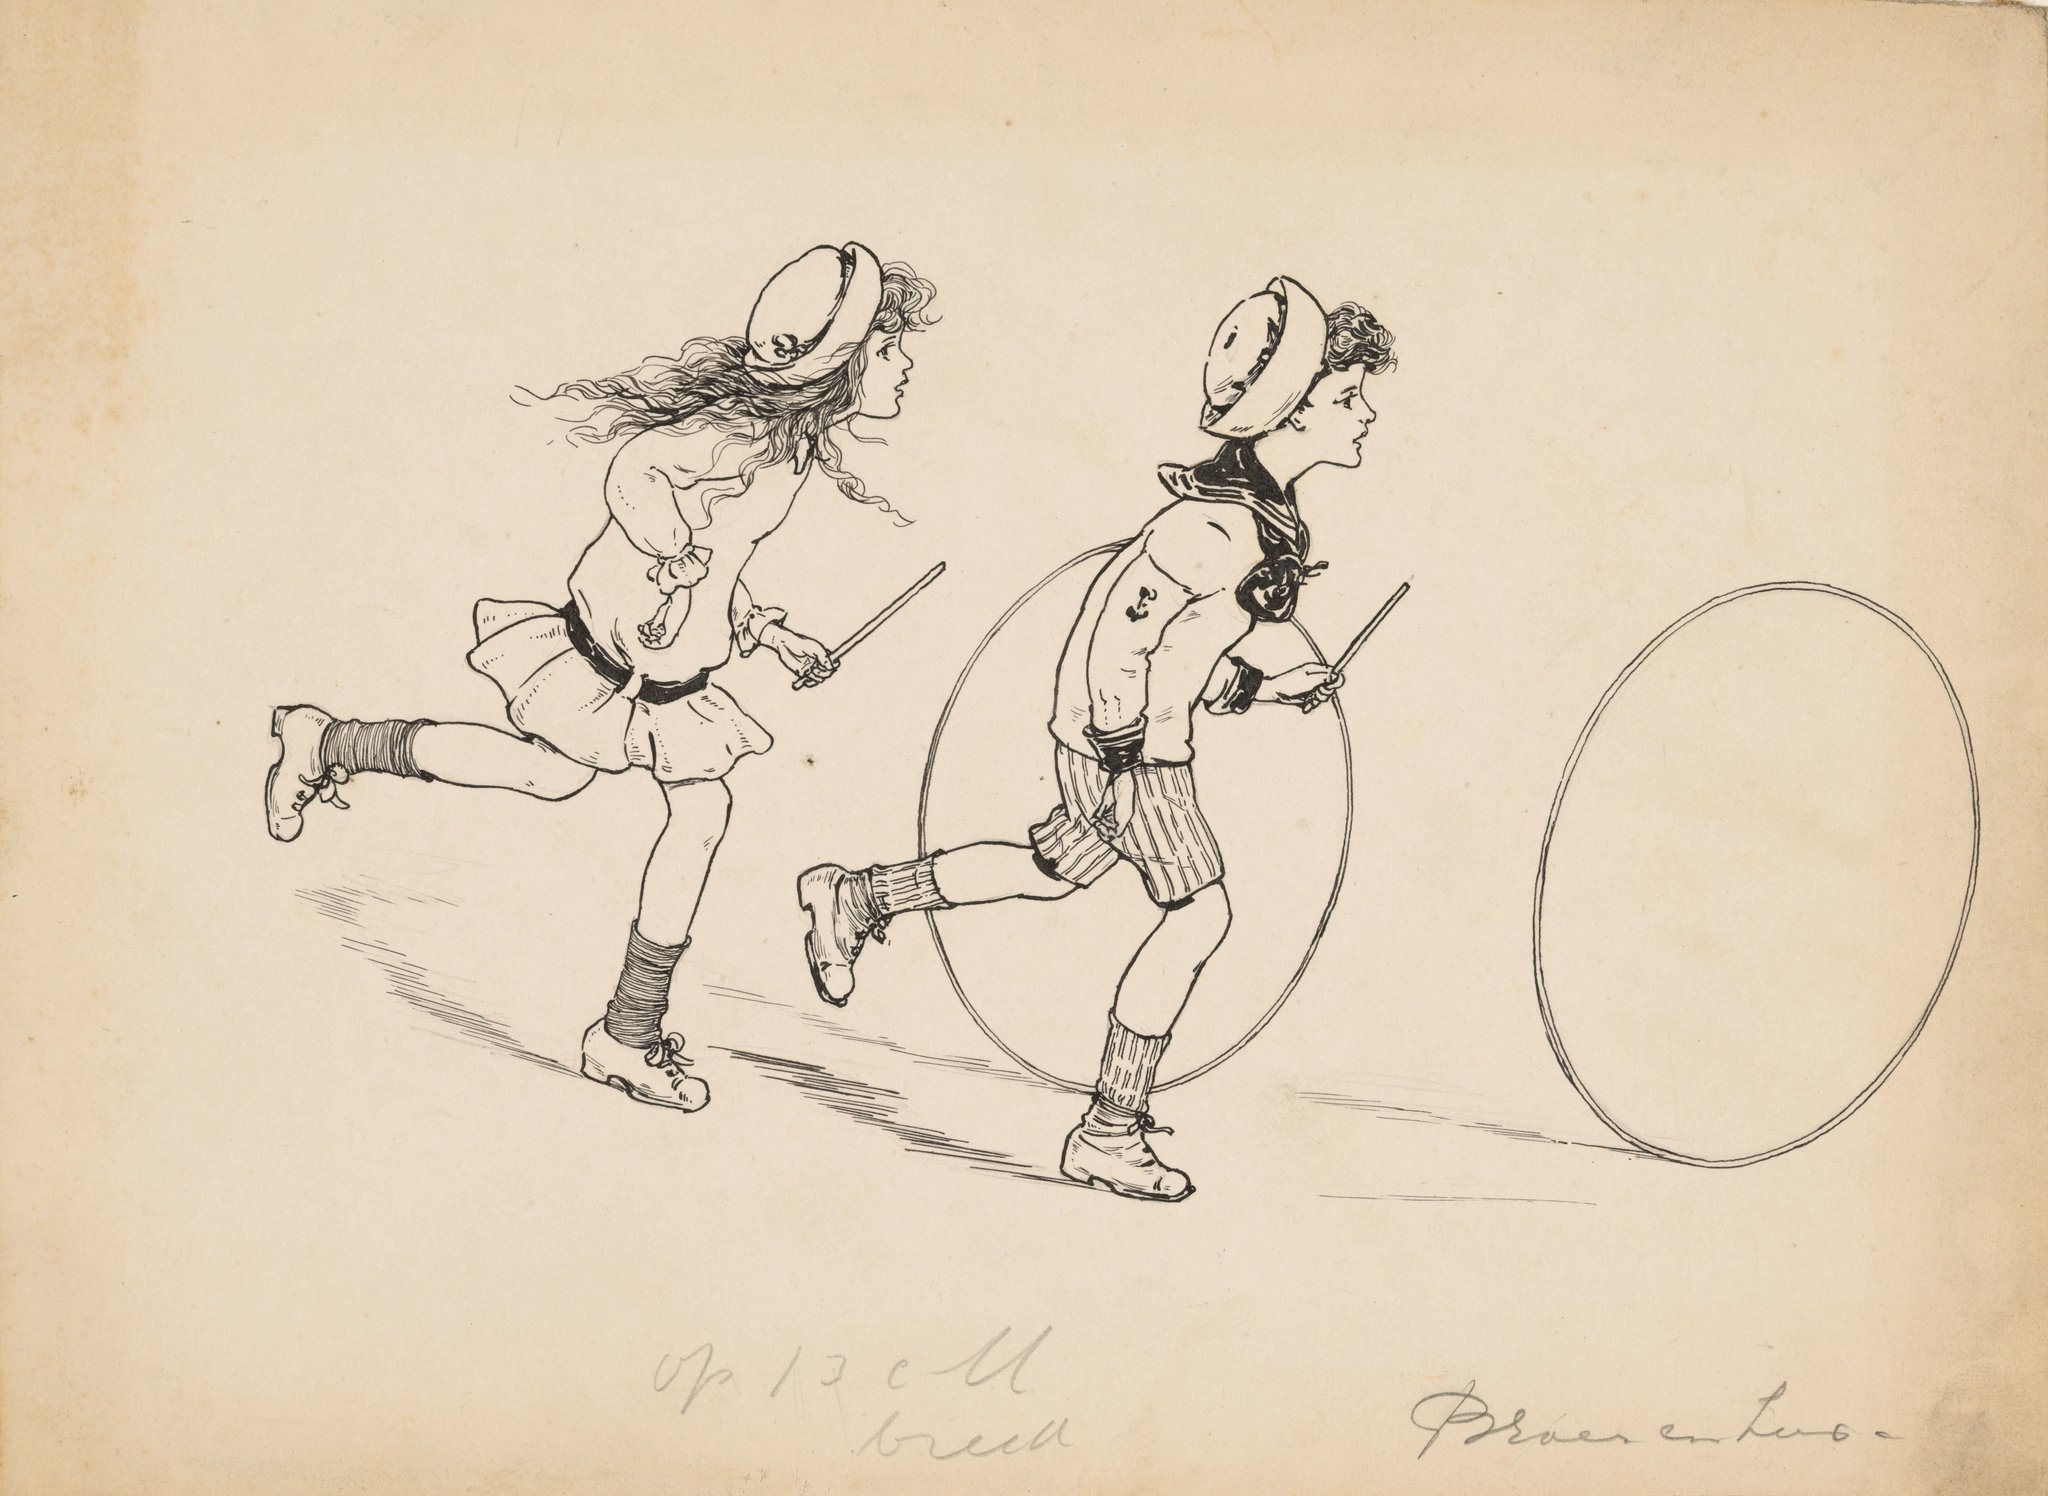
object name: boekillustratie ontwerp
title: Hoepelende broer en zus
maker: nelly spoor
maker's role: draughtsman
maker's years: 1885-1950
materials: cardboard, ink, pencil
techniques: pen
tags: (bowling a) hoop, brothers or sisters (second degree family relationships)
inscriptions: collector's mark: Lugt 2228, annotation: ‘Broer en Zus.’, :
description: Ontwerp voor: Dietz, Henriette e.a. Broer en Zus: vertellingen voor jongens en meisjes. Ons thuis-serie. Amsterdam: Veen, 1918.